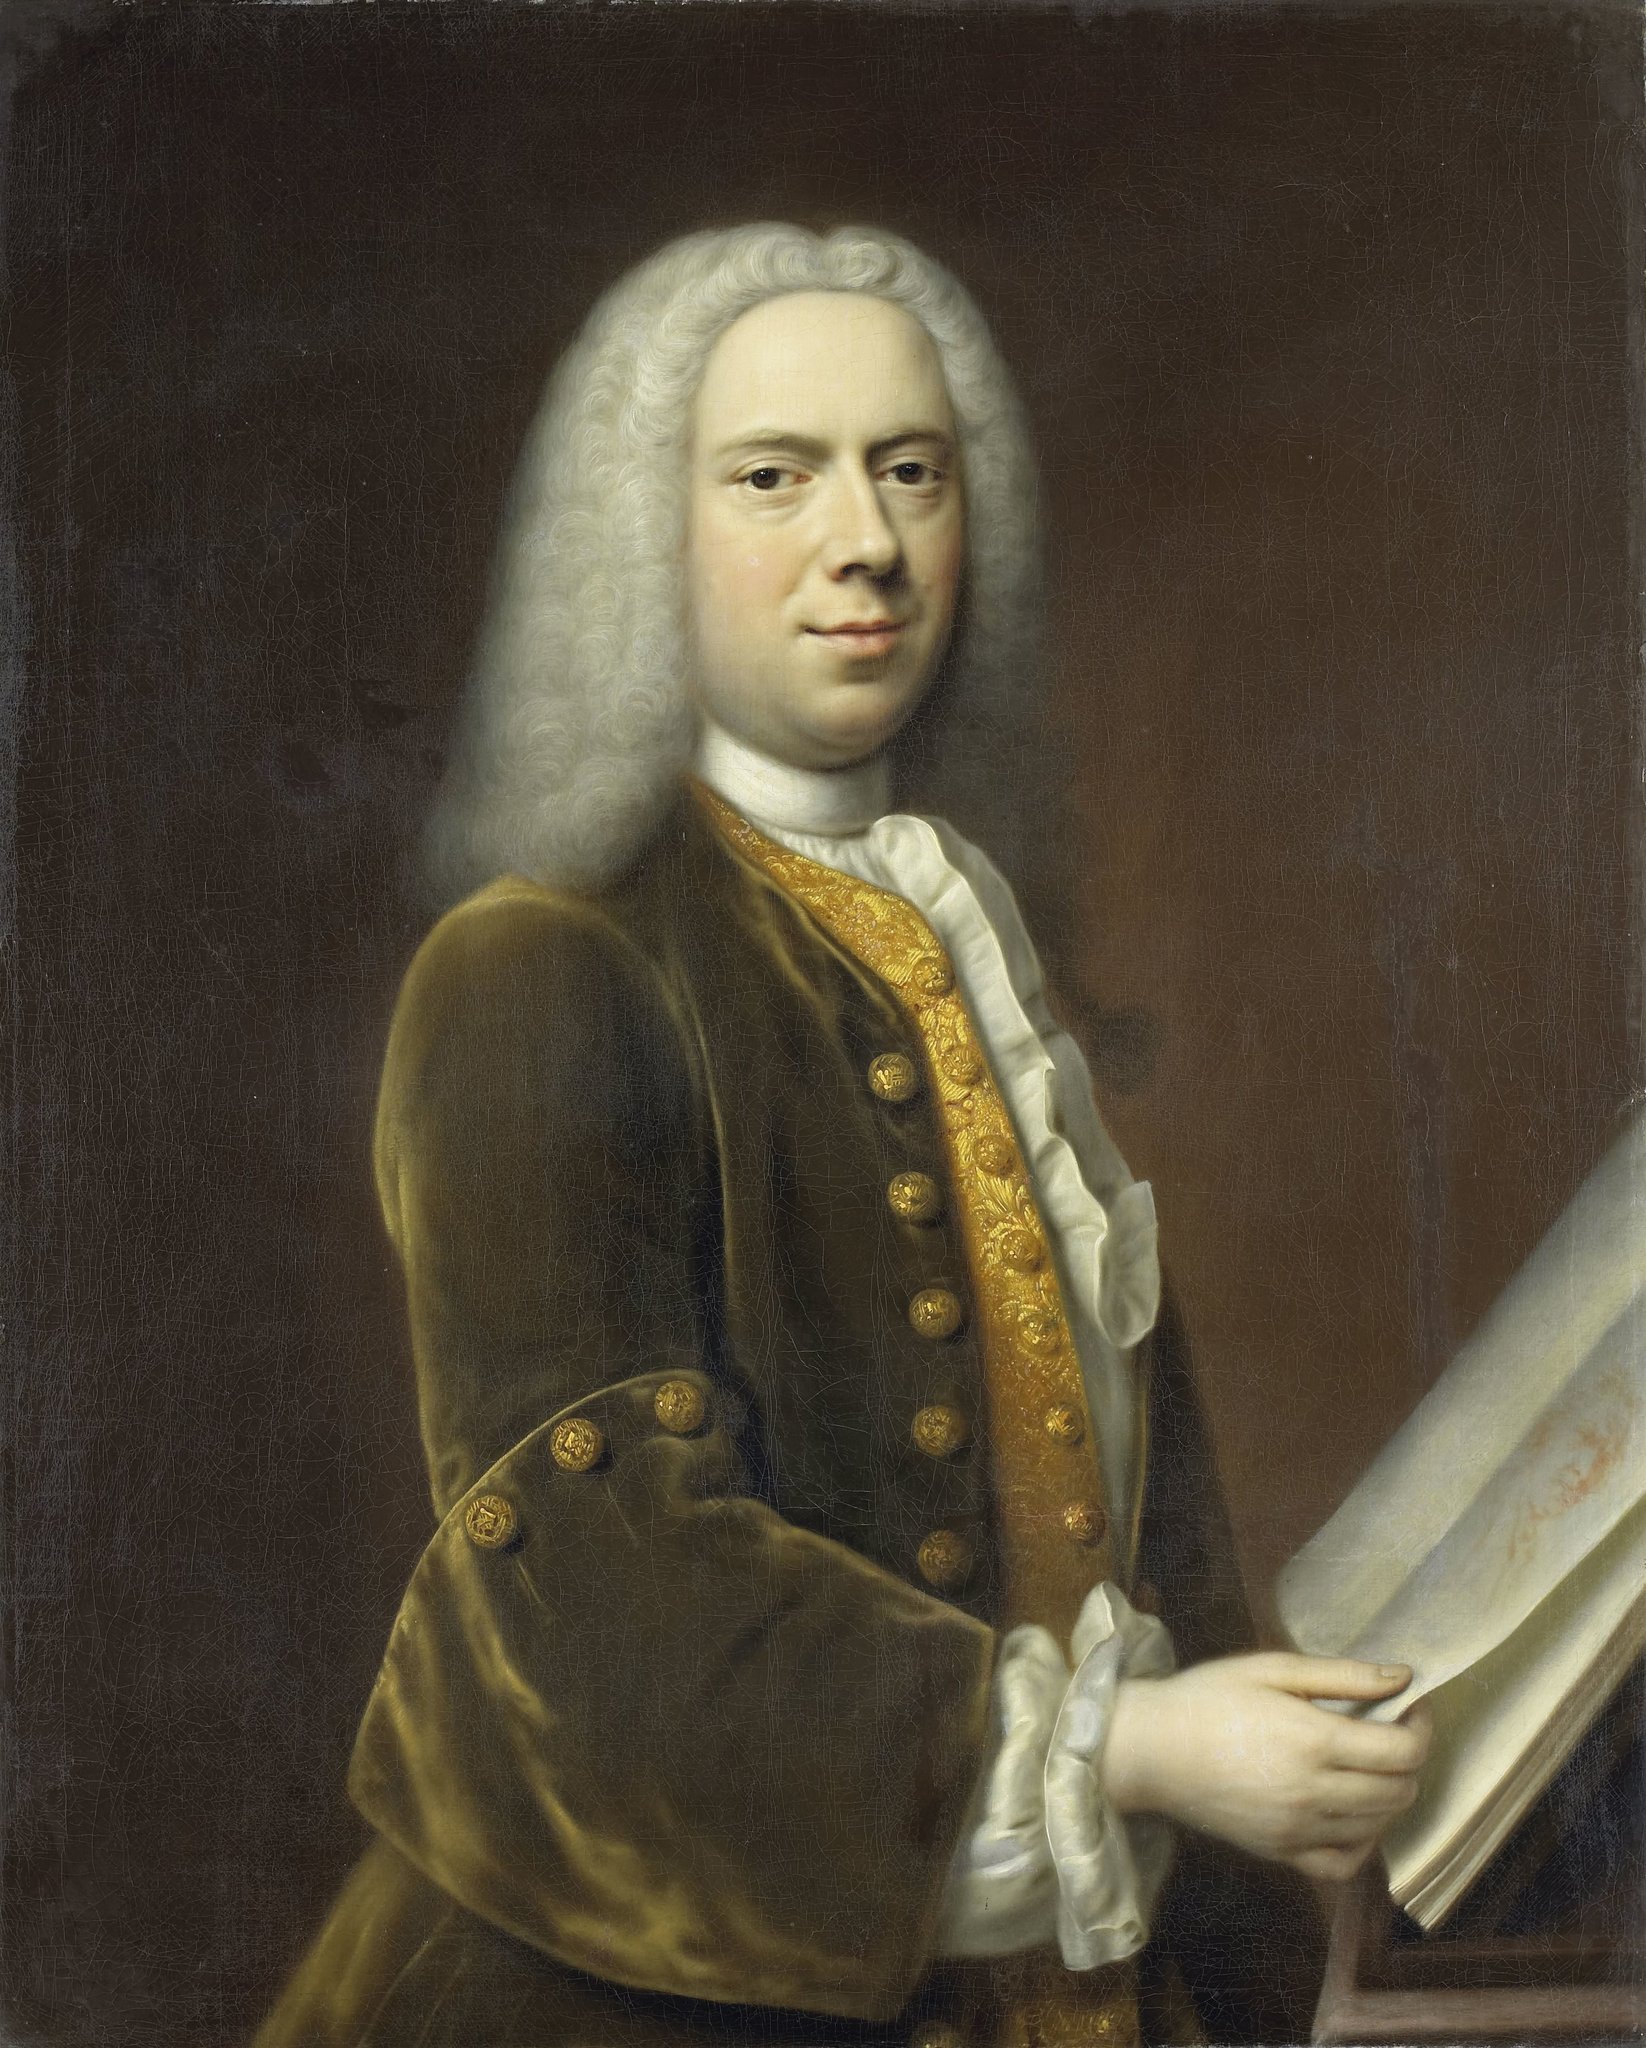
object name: painting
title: Portrait of a Man, probably Cornelis Troost (1696-1750)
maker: balthasar denner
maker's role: painter, print maker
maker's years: 1685-1749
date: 1737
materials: canvas, oil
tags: amsterdam, painter, print maker, draughtsman, cornelis troost, historical persons, portrait, self-portrait of artist, picture, painting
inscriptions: signature and date: ‘Denner 1737’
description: Portret van een man, waarschijnlijk Cornelis Troost. Staande, ten halven lijve, een boek met tekeningen in de hand.